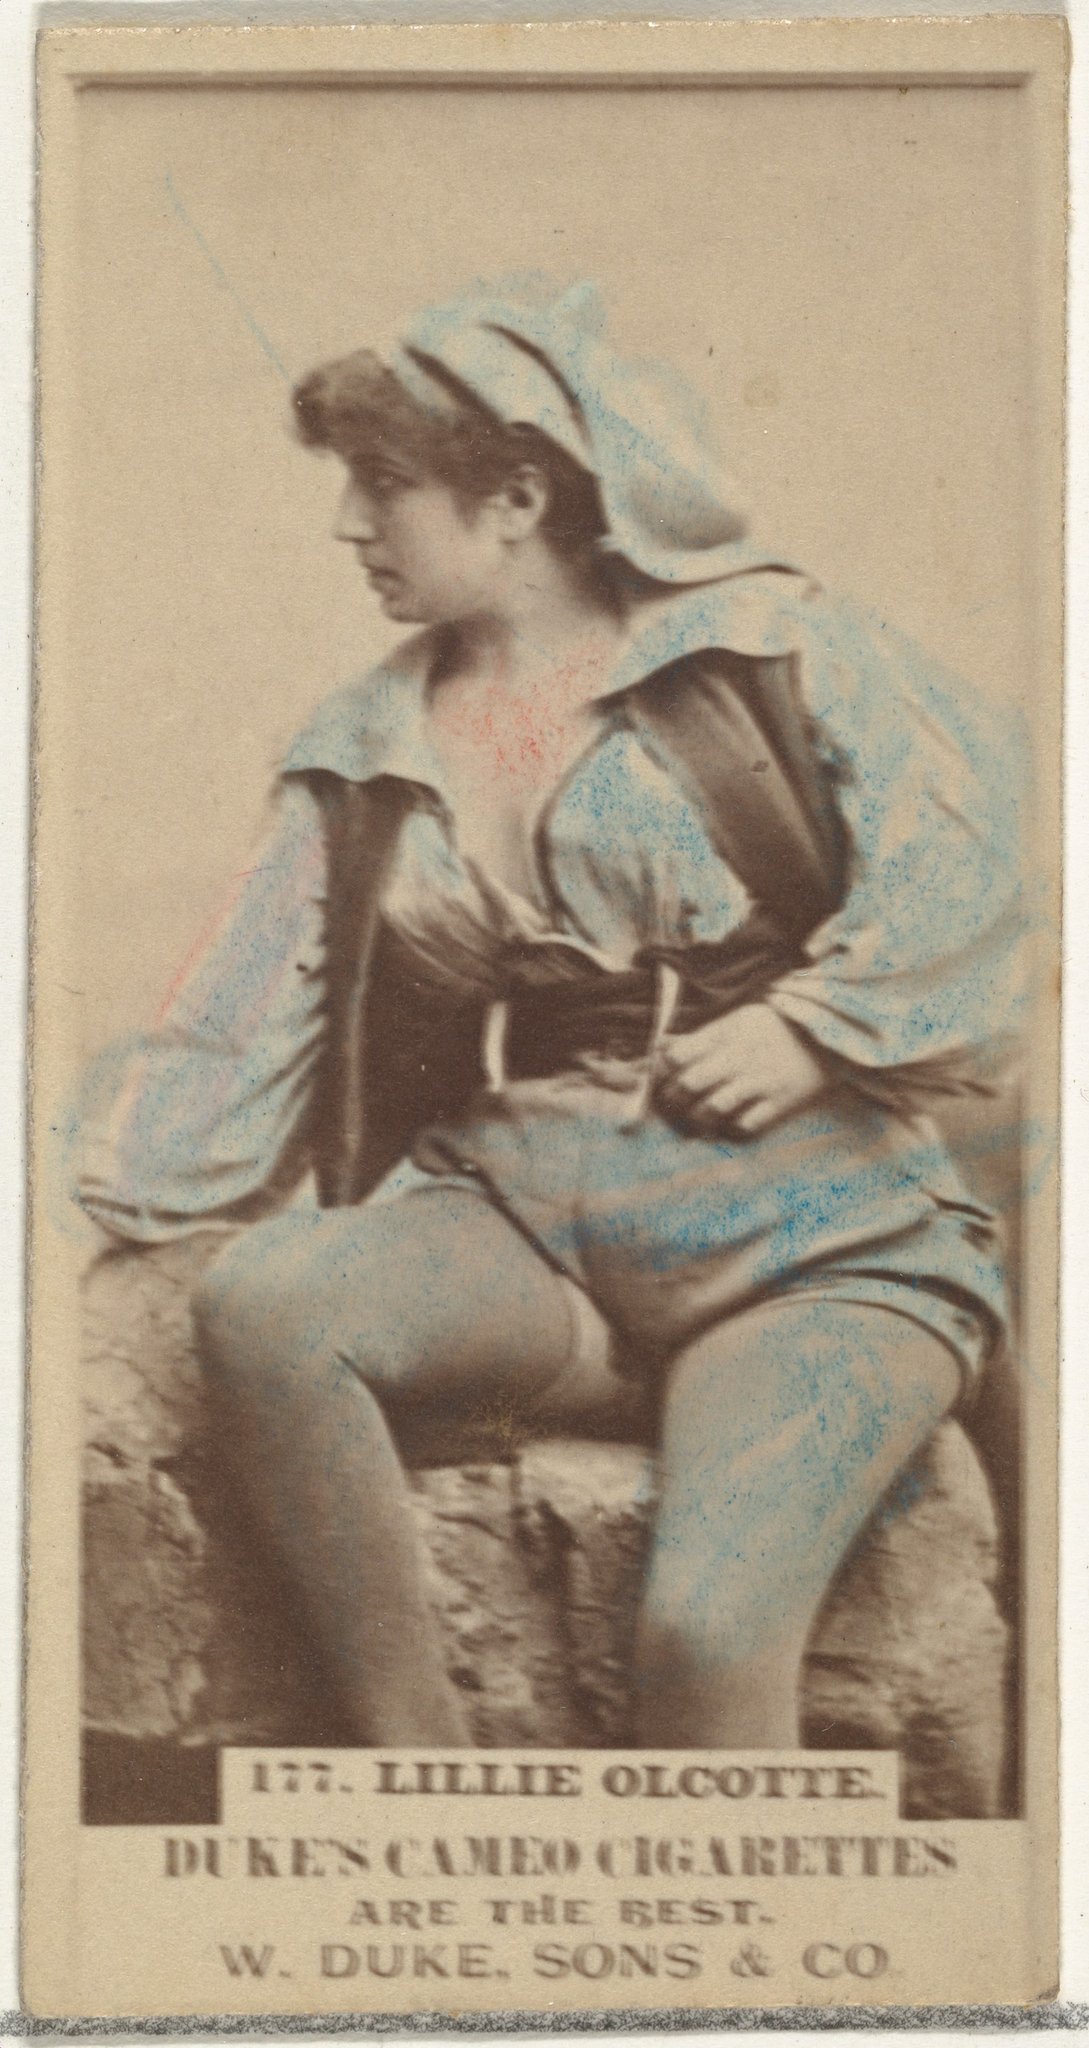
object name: photograph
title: Card Number 177, Lillie Olcotte, from the Actors and Actresses series (N145-5) issued by Duke Sons & Co. to promote Cameo Cigarettes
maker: w. duke, sons & co.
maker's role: publisher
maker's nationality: american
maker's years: 1870-1920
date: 1880-1889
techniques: albumen silver print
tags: women,actresses